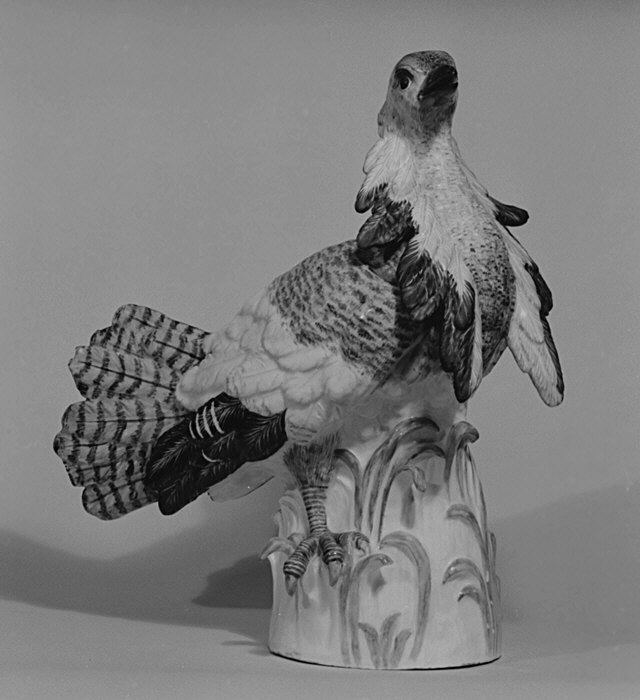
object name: figure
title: Ruffed bustard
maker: meissen manufactory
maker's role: manufactory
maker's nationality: german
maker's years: 1710-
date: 1752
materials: hard paste porcelain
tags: birds